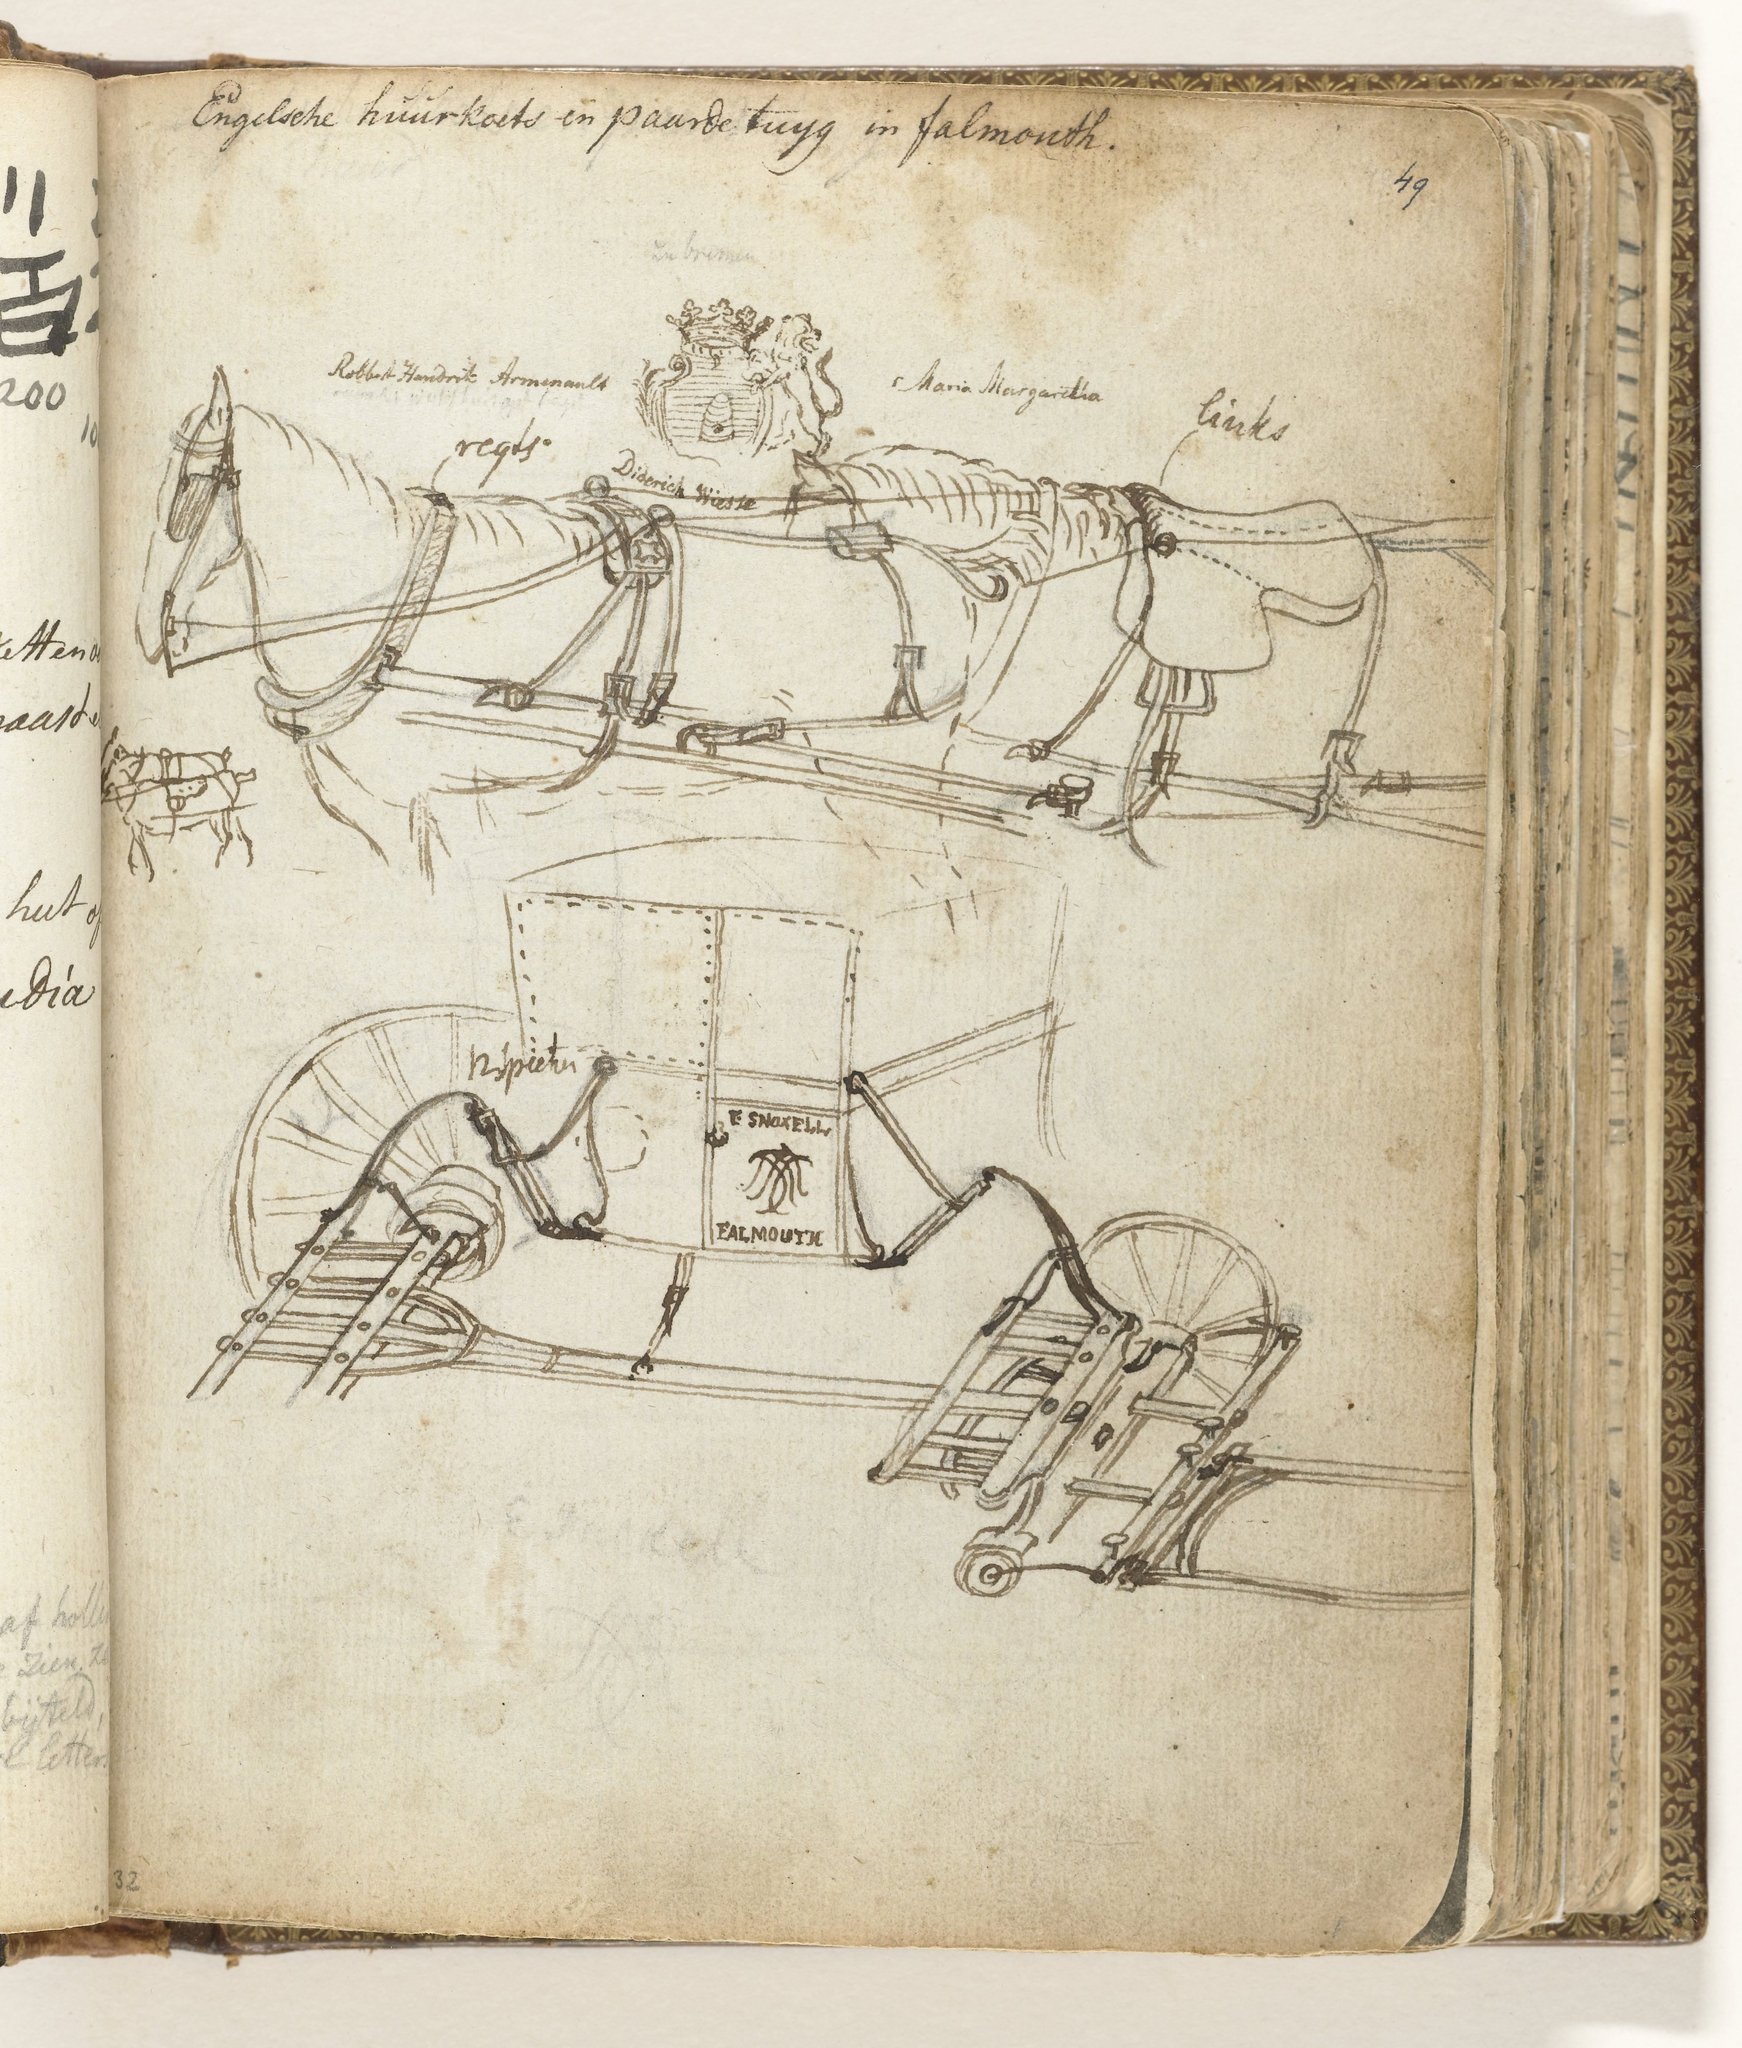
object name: drawing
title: Engels huurkoets en paardentuig in Falmouth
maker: jan brandes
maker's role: draughtsman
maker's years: 1743-1808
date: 1778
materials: ink, paper, pencil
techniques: pen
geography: falmouth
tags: four-wheeled, animal-drawn vehicle, e.g.: cab, carriage, coach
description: Pentekening van een wapen met honingraat, paarden in tuig, de huif van een koets en het chassis van een koets. Zie deel 2, pp. 50, 65. Met opschrift. Onderdeel uit het schetsboek van Jan Brandes, dl. 2 (1808), p. 49.